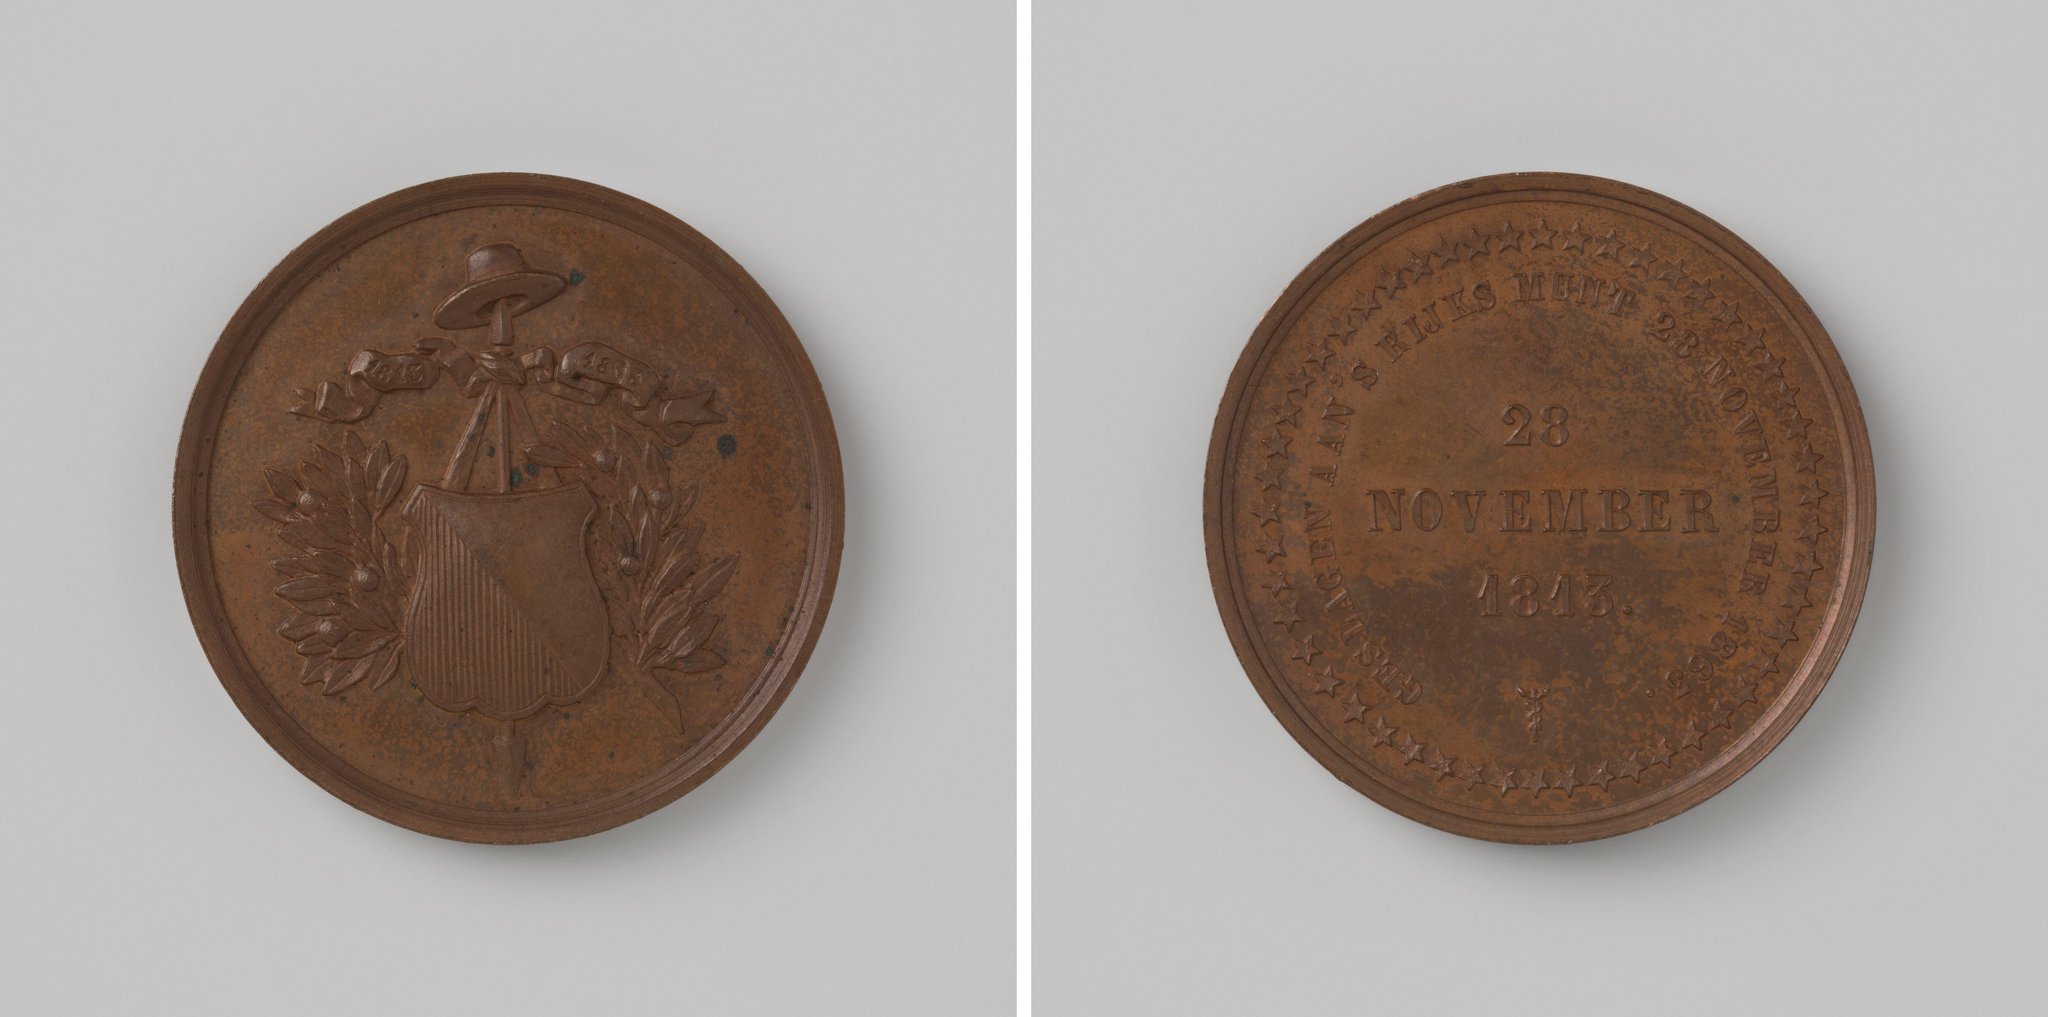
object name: history medal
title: Vijftigjarige herdenking van het verschijnen van kozakken voor Utrecht (Kozakjes-dag) 1863, groot model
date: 1863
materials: bronze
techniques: striking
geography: utrecht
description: Bronzen penning, op de voorzijde het Utrechtse stadswapenschild, tussen lauwertakken, aan een lans met een vrijheidshoed en een lint beschreven 1813 - 1863, op de keerzijde drie regels tekst met omschrift binnen een krans van vijftig sterren.